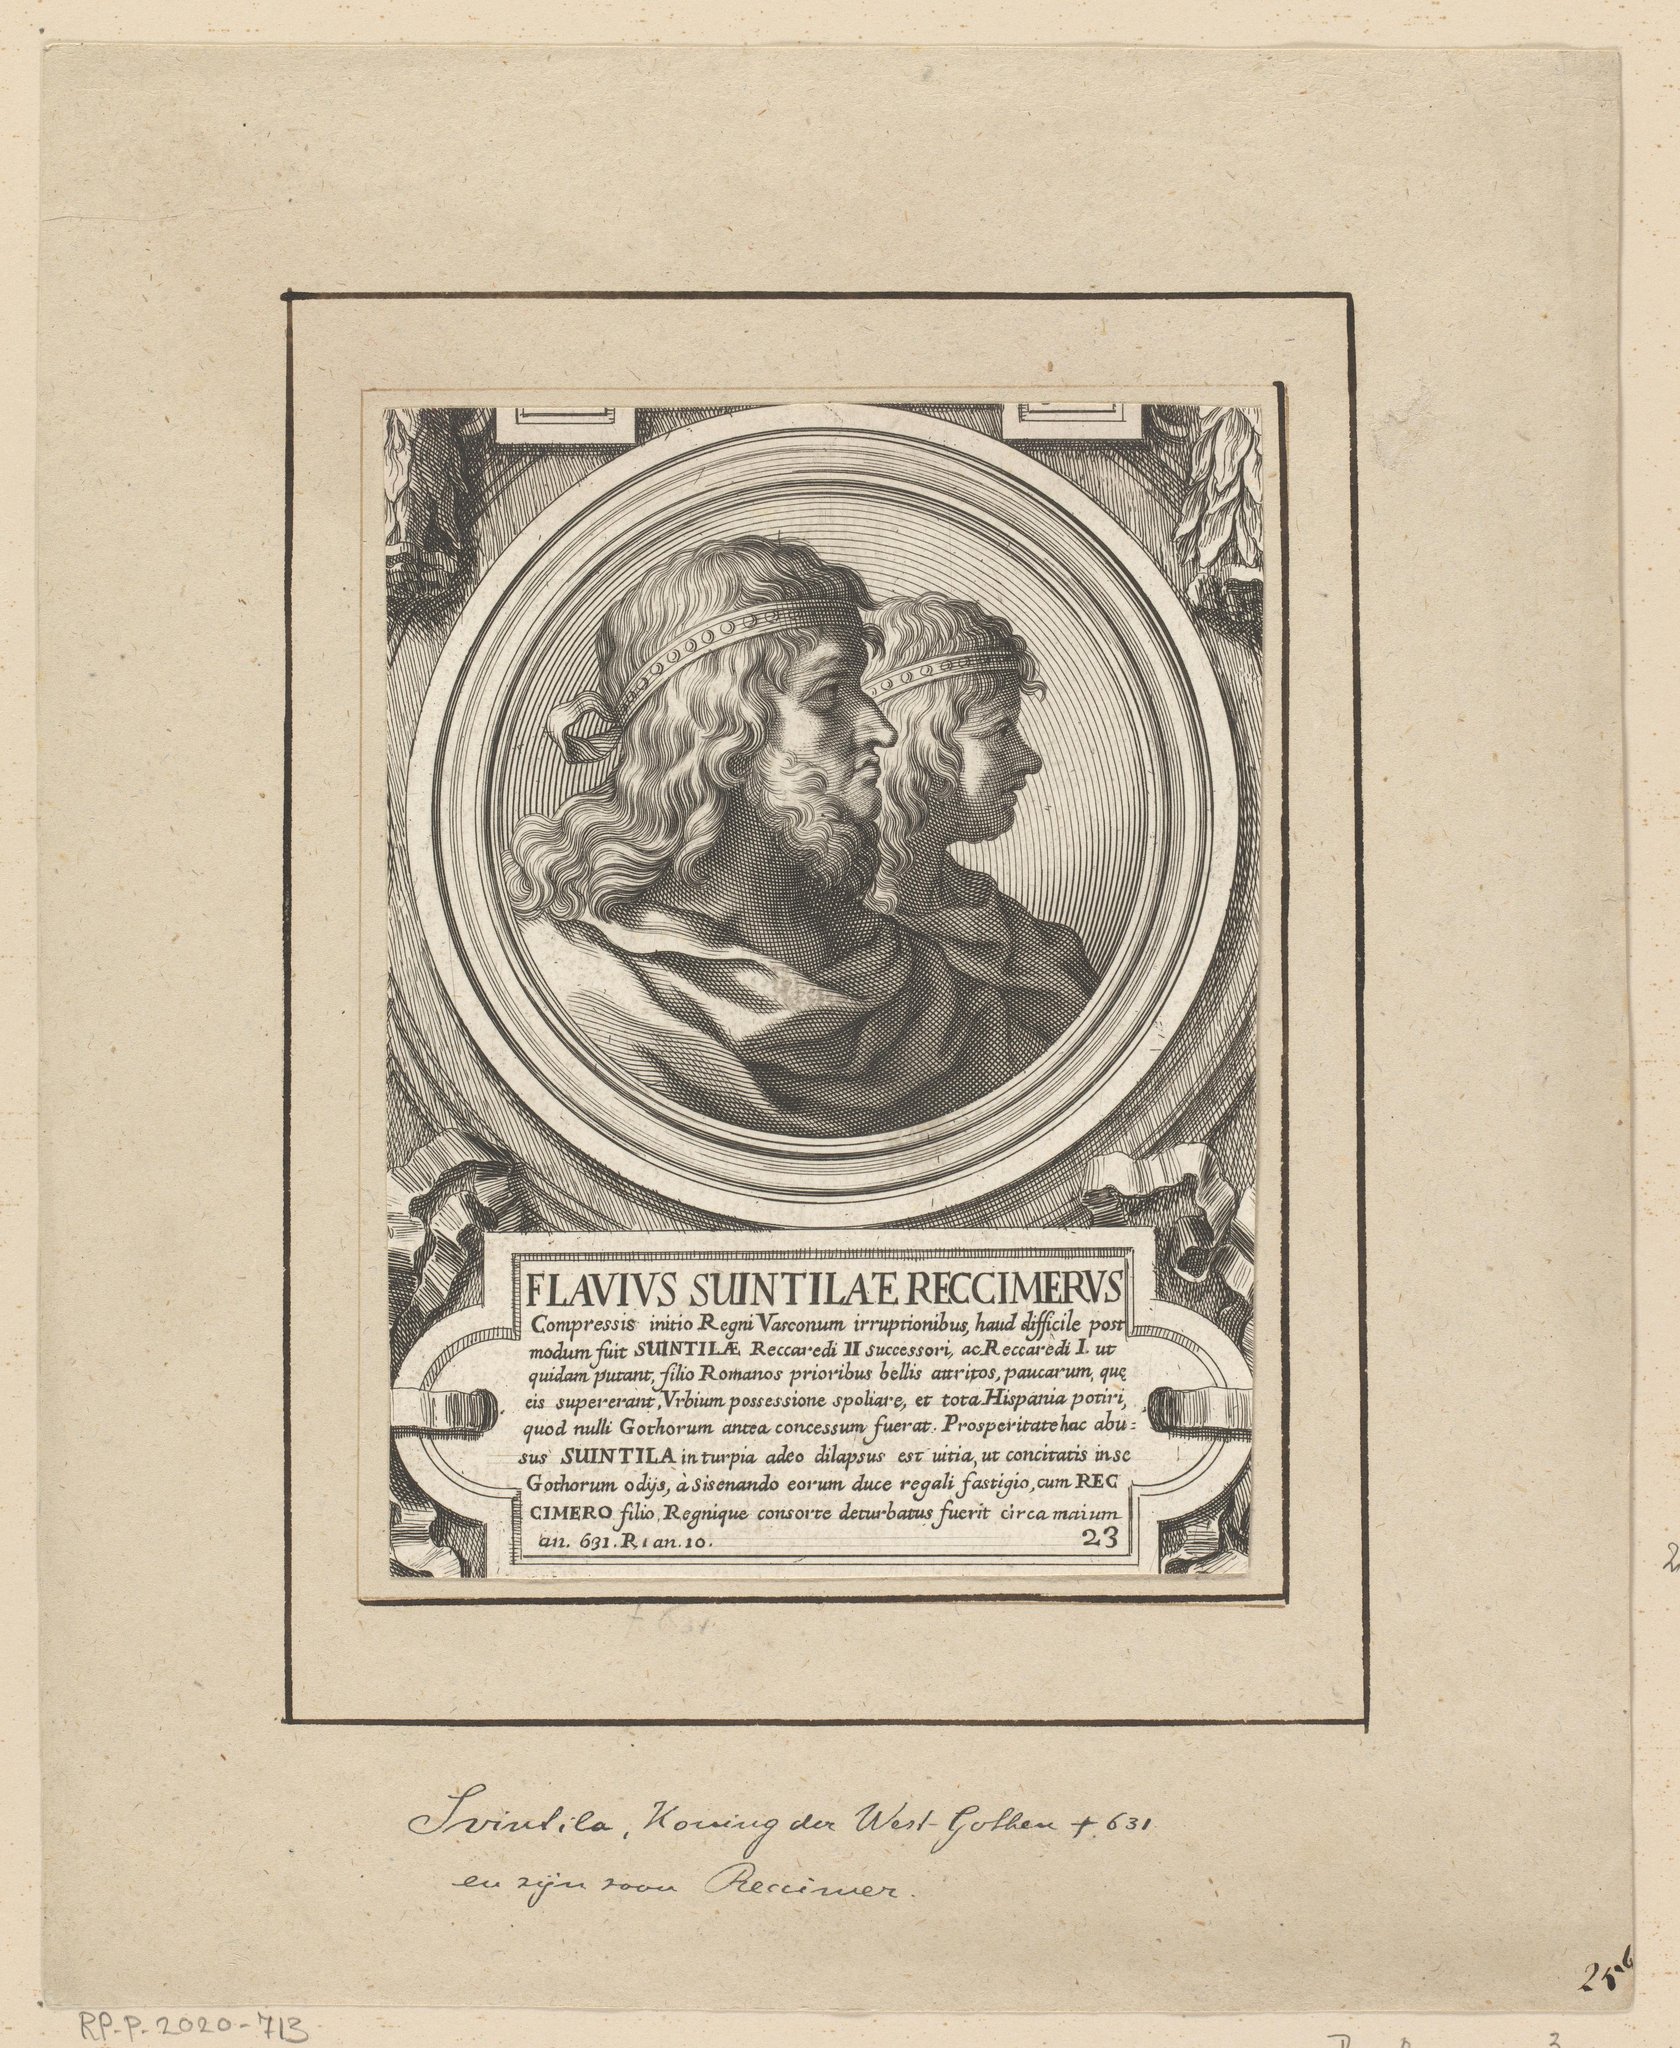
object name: print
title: Flavius Suintilae Reccimerus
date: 1685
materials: paper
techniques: engraving, etching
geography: rome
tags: historical persons, ruler, sovereign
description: Portret afkomstig van een grote prent, getiteld 'Series Chronologica et Imagines Regu Hispaniae ab Ataulpho ad Carolum II', bestaande uit tien bladen die samengevoegd konden worden, uitgegeven door Giovanni Giacomo de' Rossi in 1685.